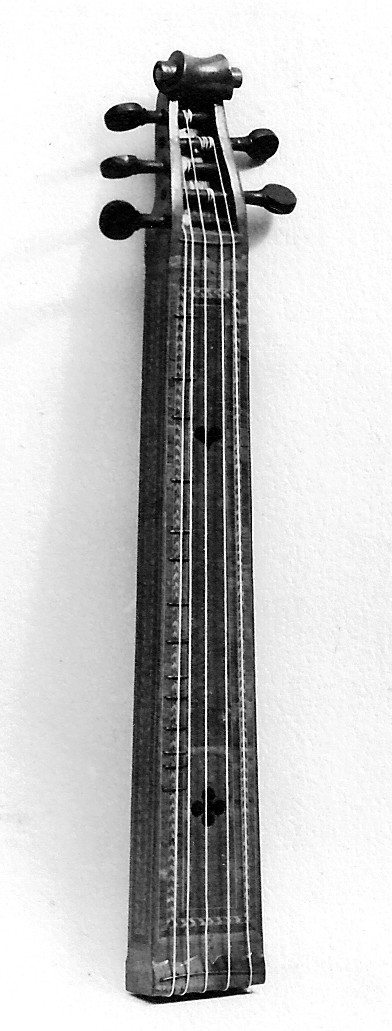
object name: épinette de vosges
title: Epinette des Vosges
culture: french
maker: amant constant (amé) lambert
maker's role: maker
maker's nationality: french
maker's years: 1843-1908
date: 1867-1900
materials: metal, wood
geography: france